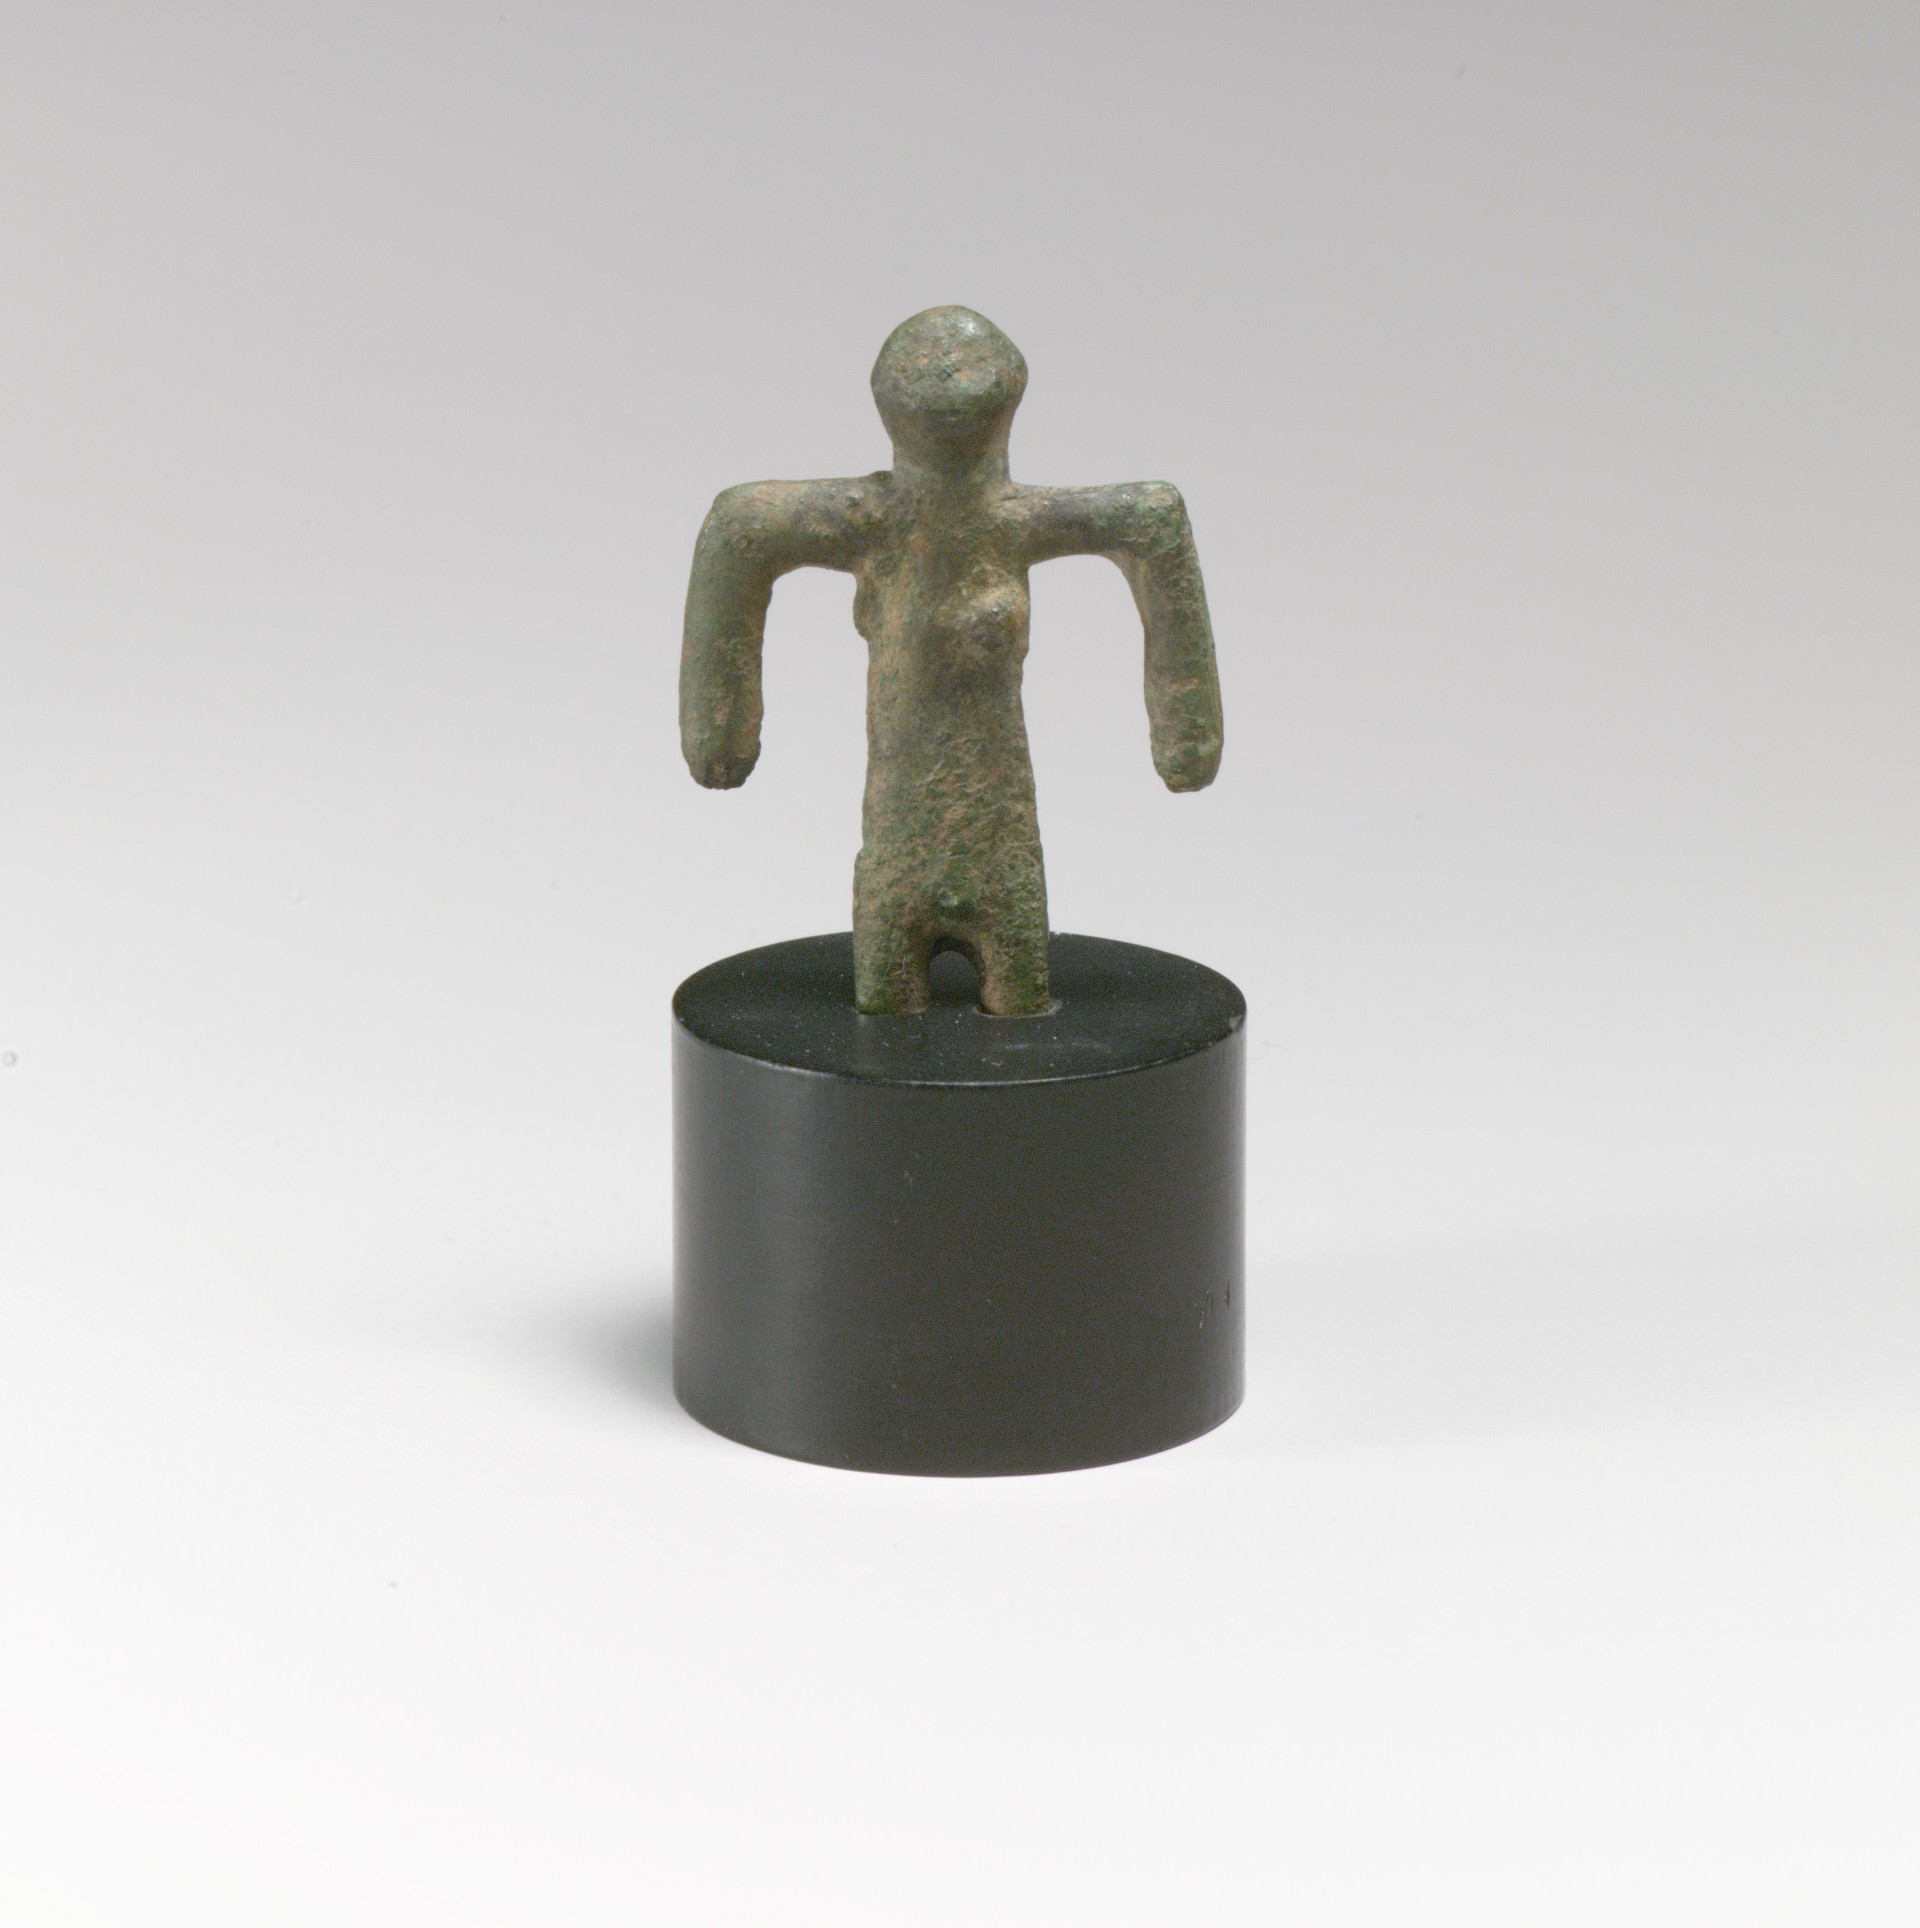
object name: statuette of a man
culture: italic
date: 601-700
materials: bronze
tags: men